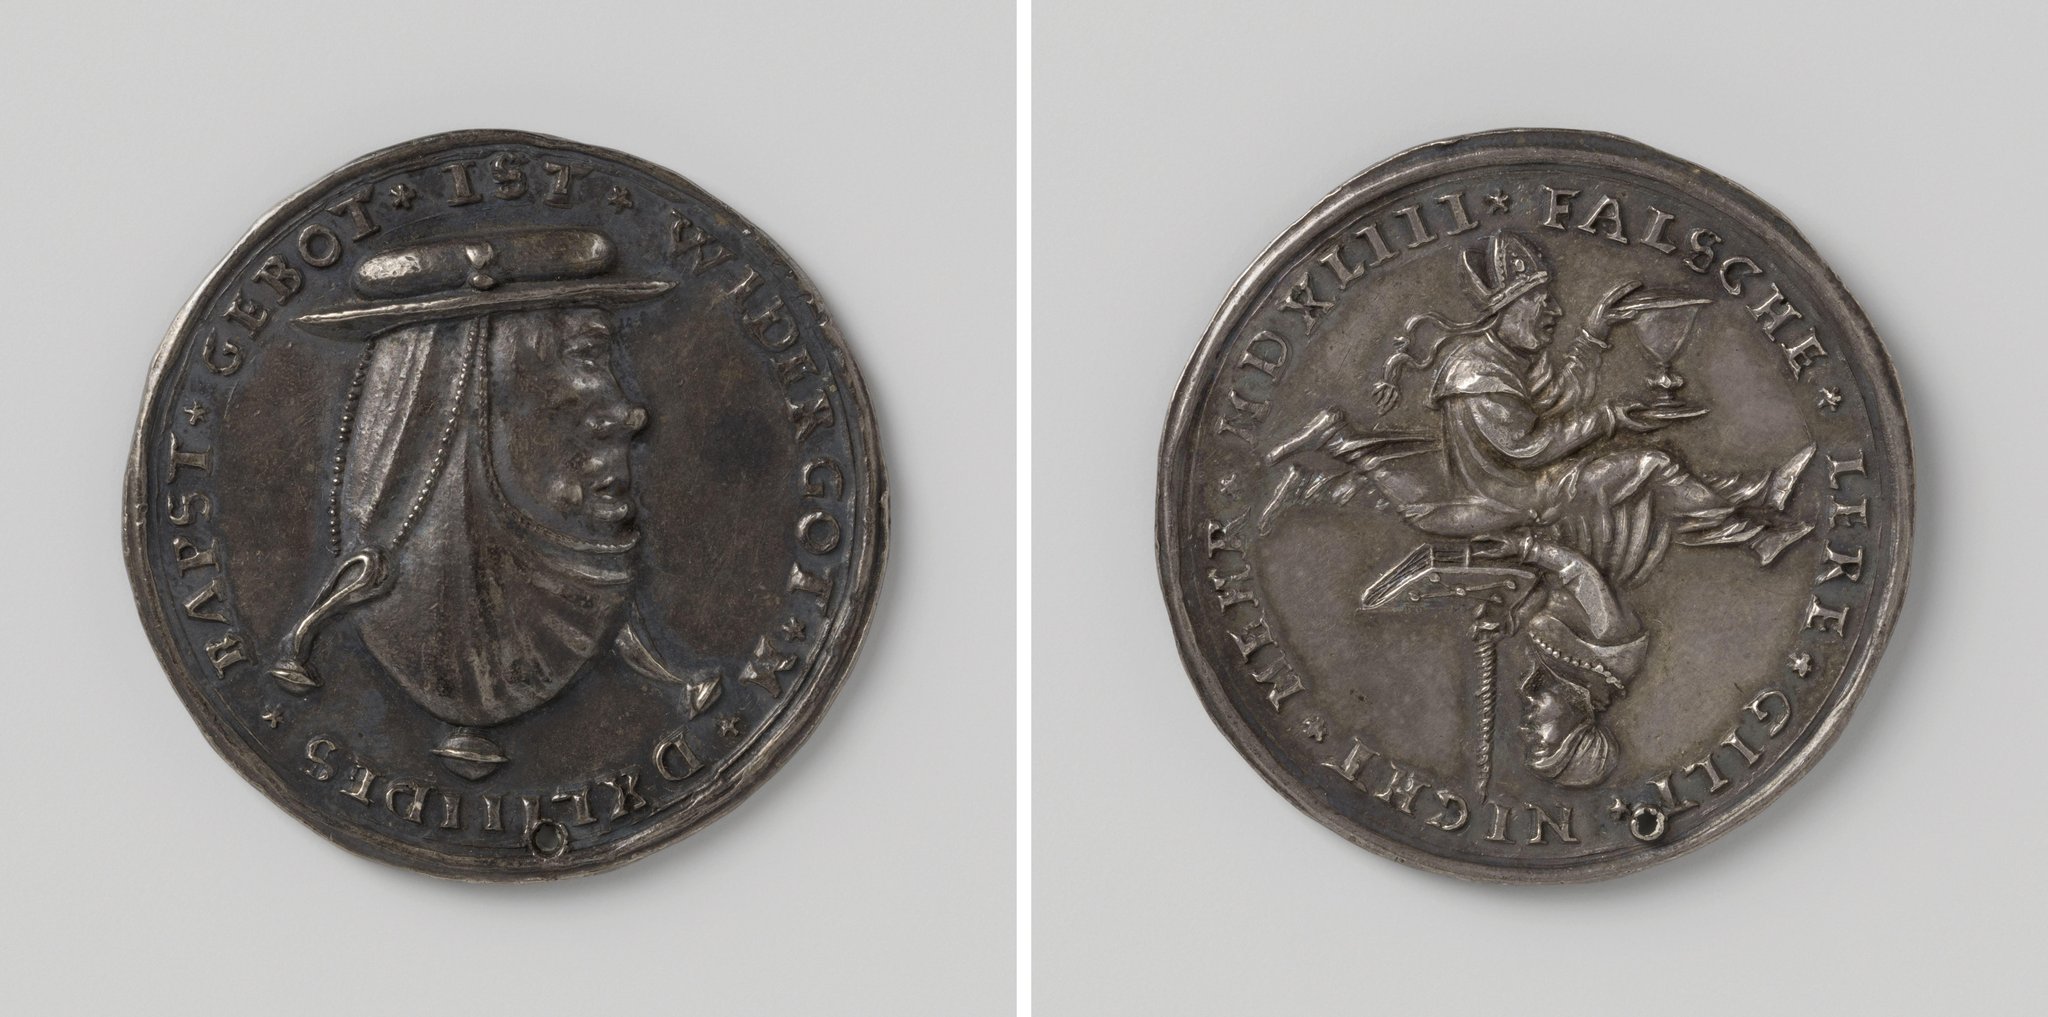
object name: satirical medal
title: Bespotting van de Rooms-Katholieke Kerk, naar aanleiding van het Concilie van Trente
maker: friedrich hagenauer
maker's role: medailleur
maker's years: 1499-1546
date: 1543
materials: silver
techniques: striking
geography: cologne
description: Zilveren penning met gat erin. Voorzijde: in elkaar overlopende kop van kardinaal (boven) en nar (onder) binnen omschrift. Keerzijde: bisschop met kelk en vrouw met kaars en boek, ruggelings met elkaar verbonden binnen omschrift